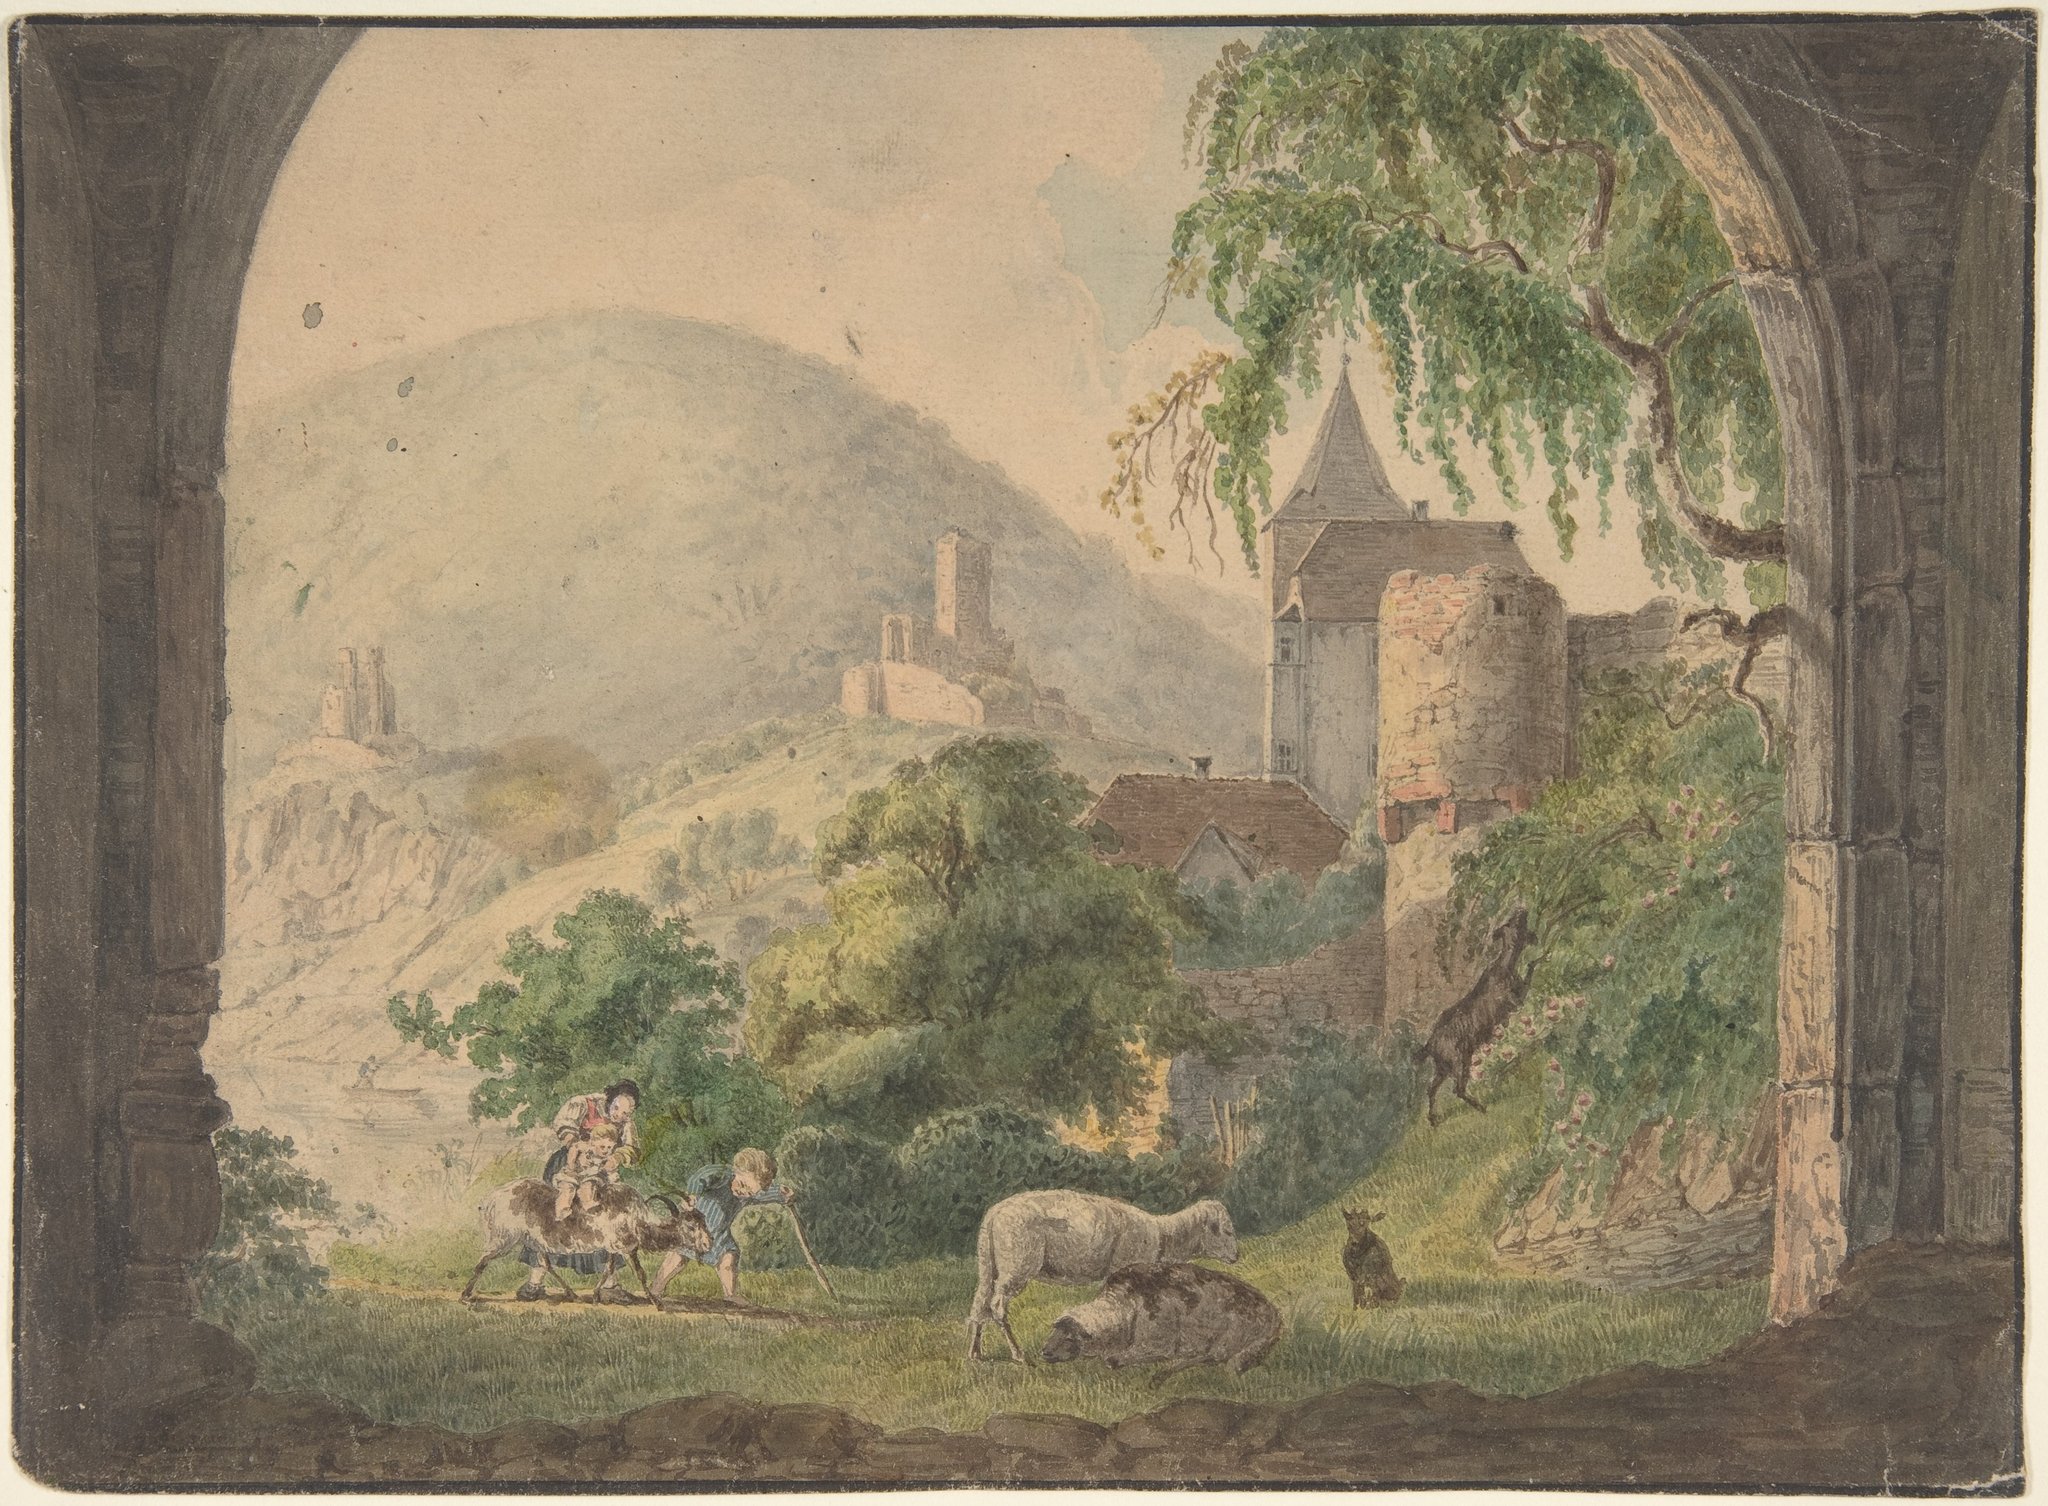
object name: drawing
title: The Four Castles of Neckarsteinach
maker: carl philipp fohr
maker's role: artist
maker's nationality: german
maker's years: 1795-1818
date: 1800-1818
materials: ink, watercolor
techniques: brush, pen, wash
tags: castles,boys,women,goats,sheep